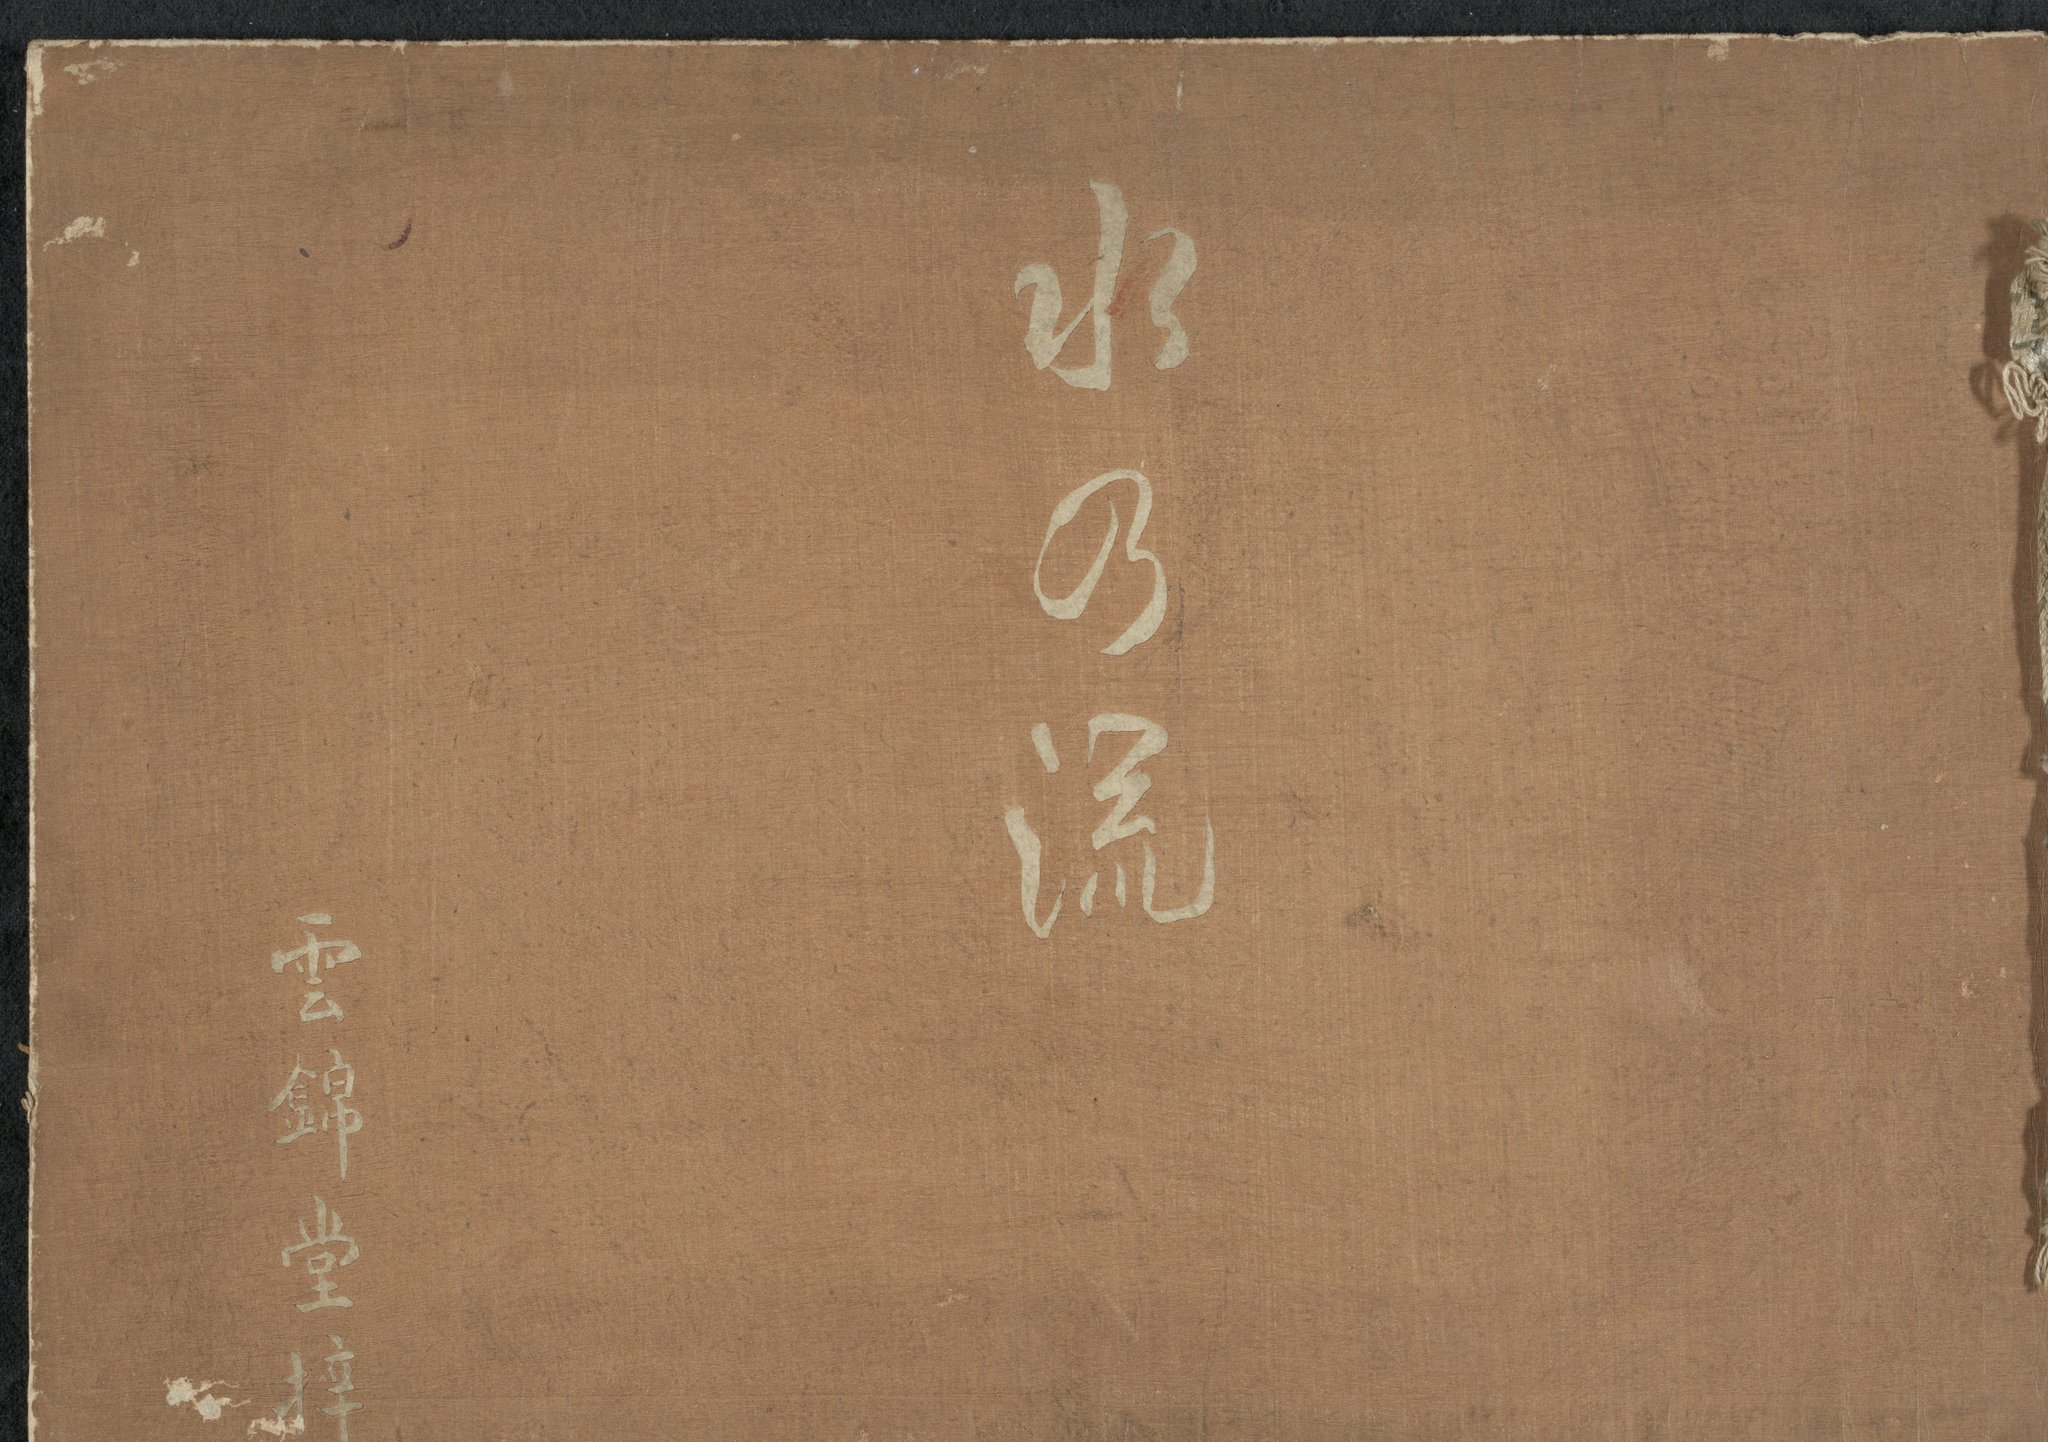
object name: book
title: Mizu no nagare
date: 1904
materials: paper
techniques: woodcut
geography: japan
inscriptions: date